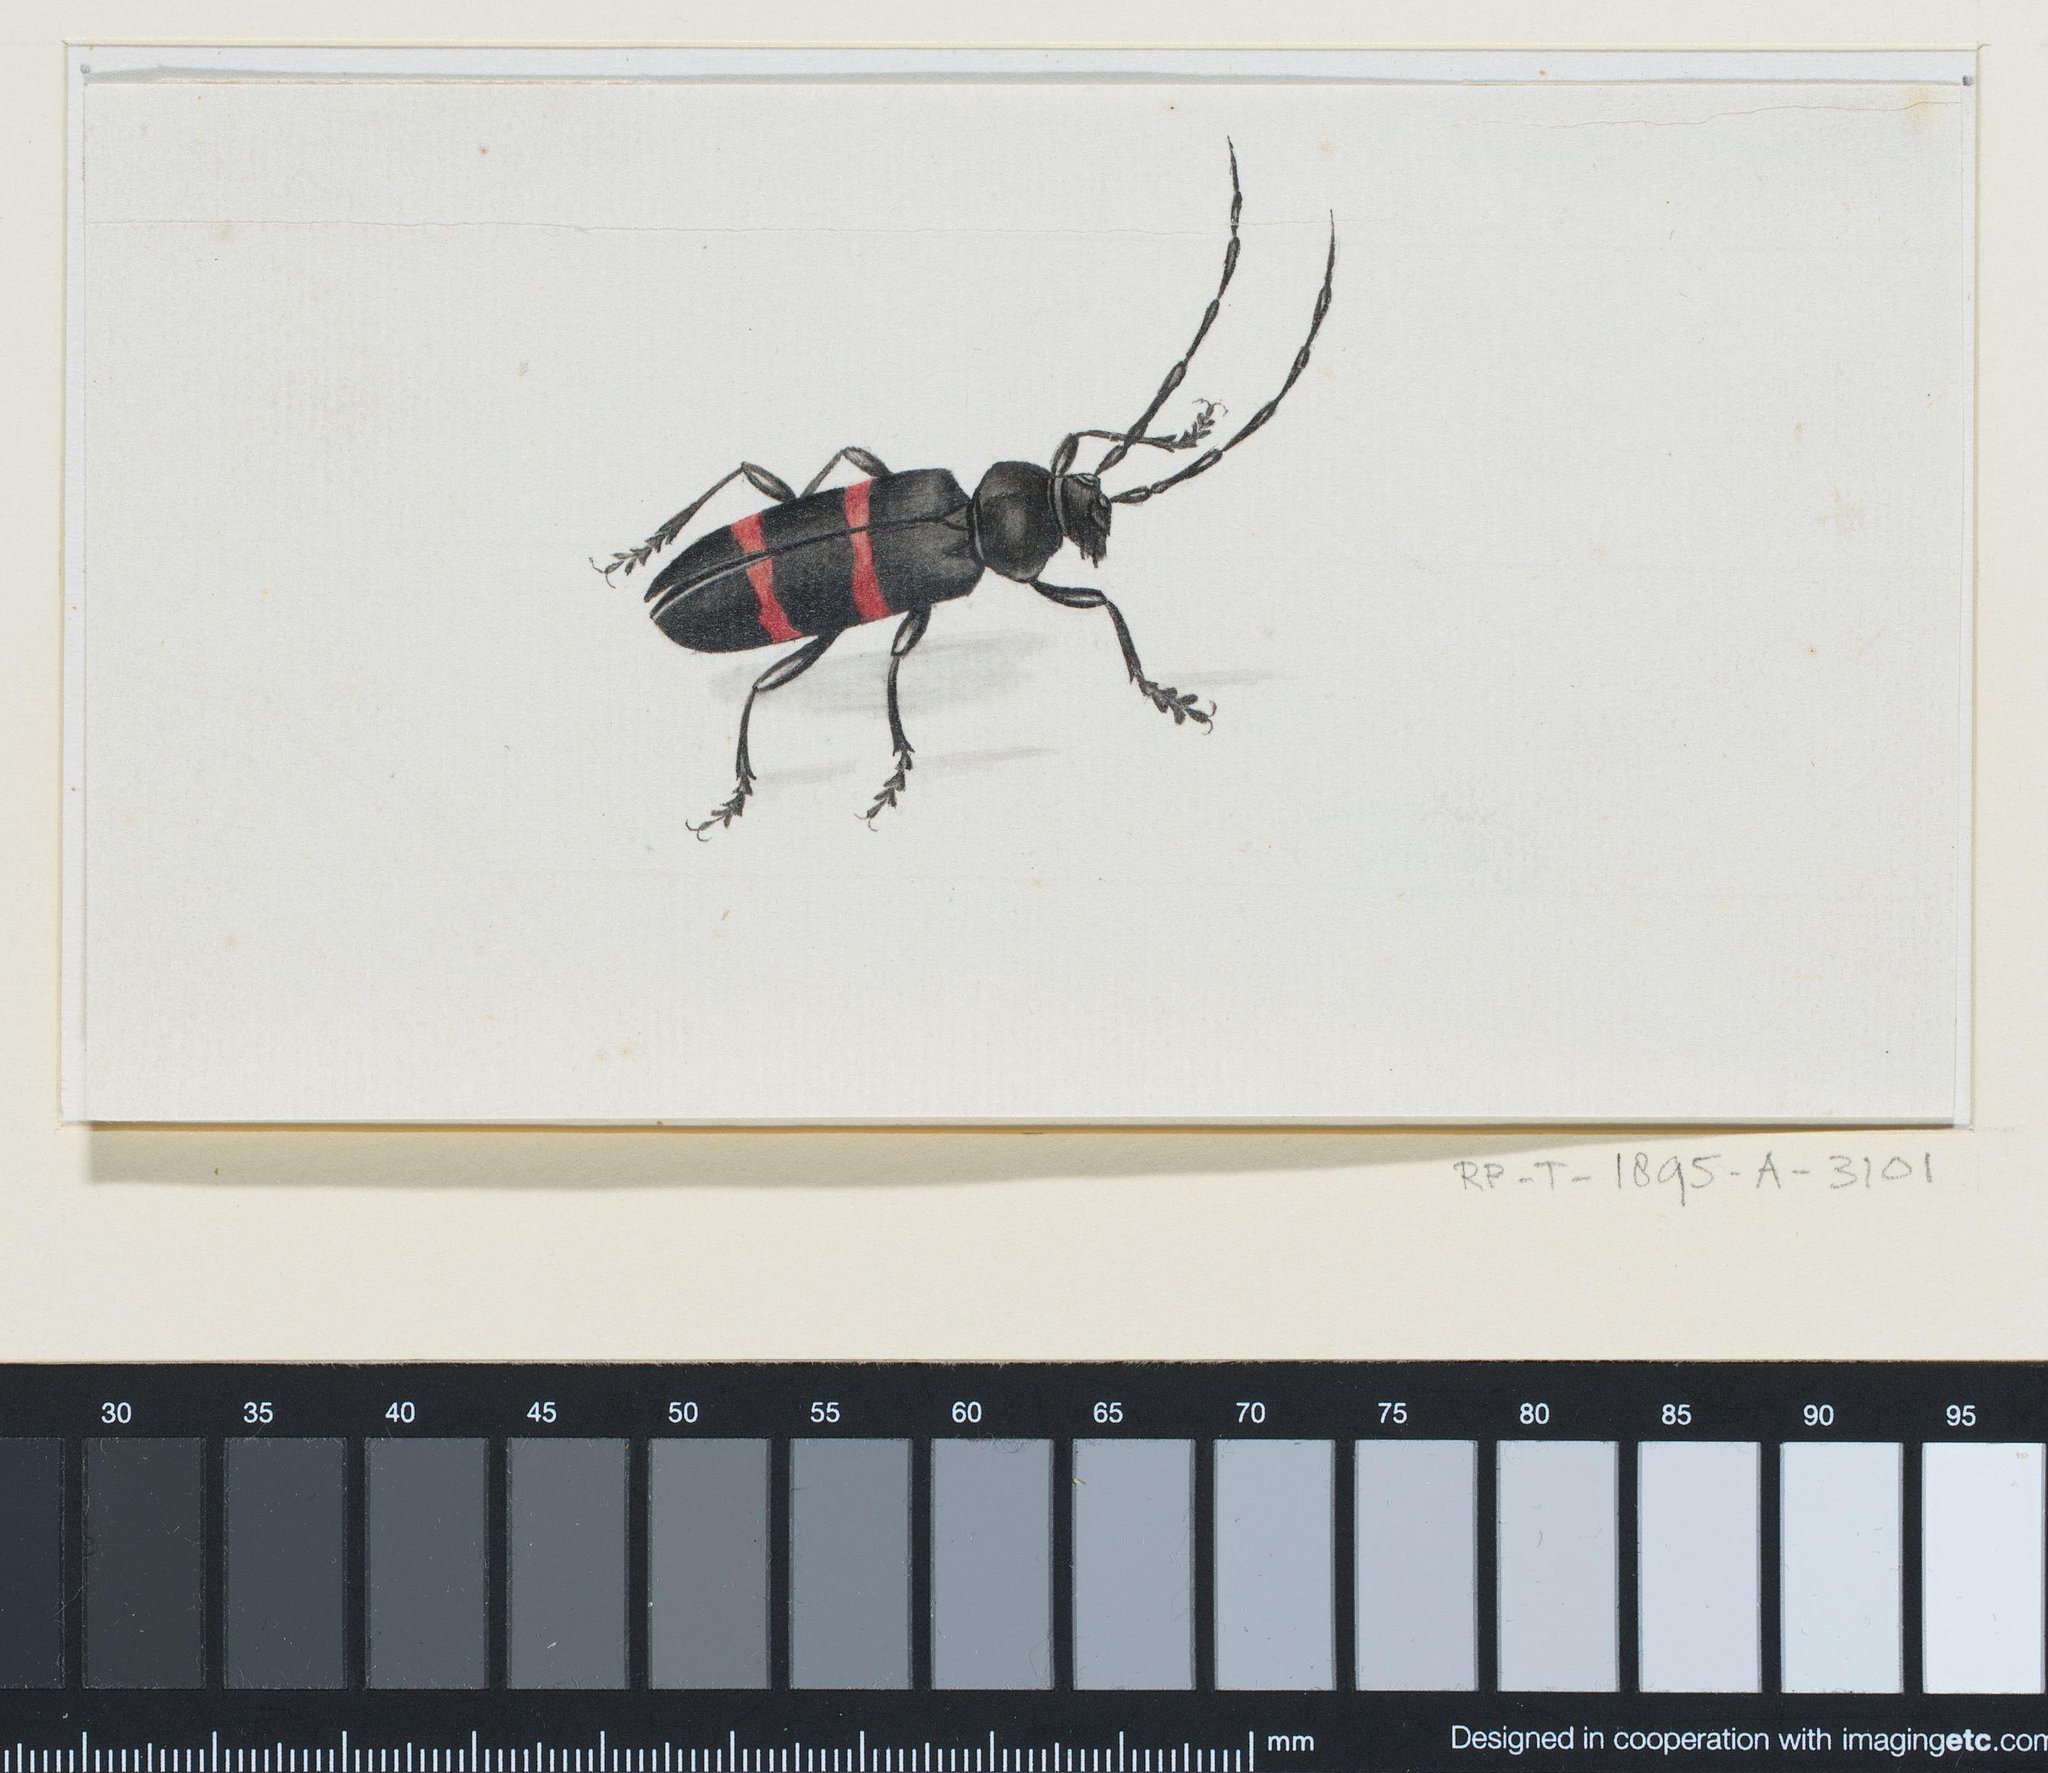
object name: drawing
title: Boktor, naar rechts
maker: adriaan van der willigen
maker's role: draughtsman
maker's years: 1766-1841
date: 1825-1895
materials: ink, paper, pencil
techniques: brush, pen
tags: insects: long-horned beetle